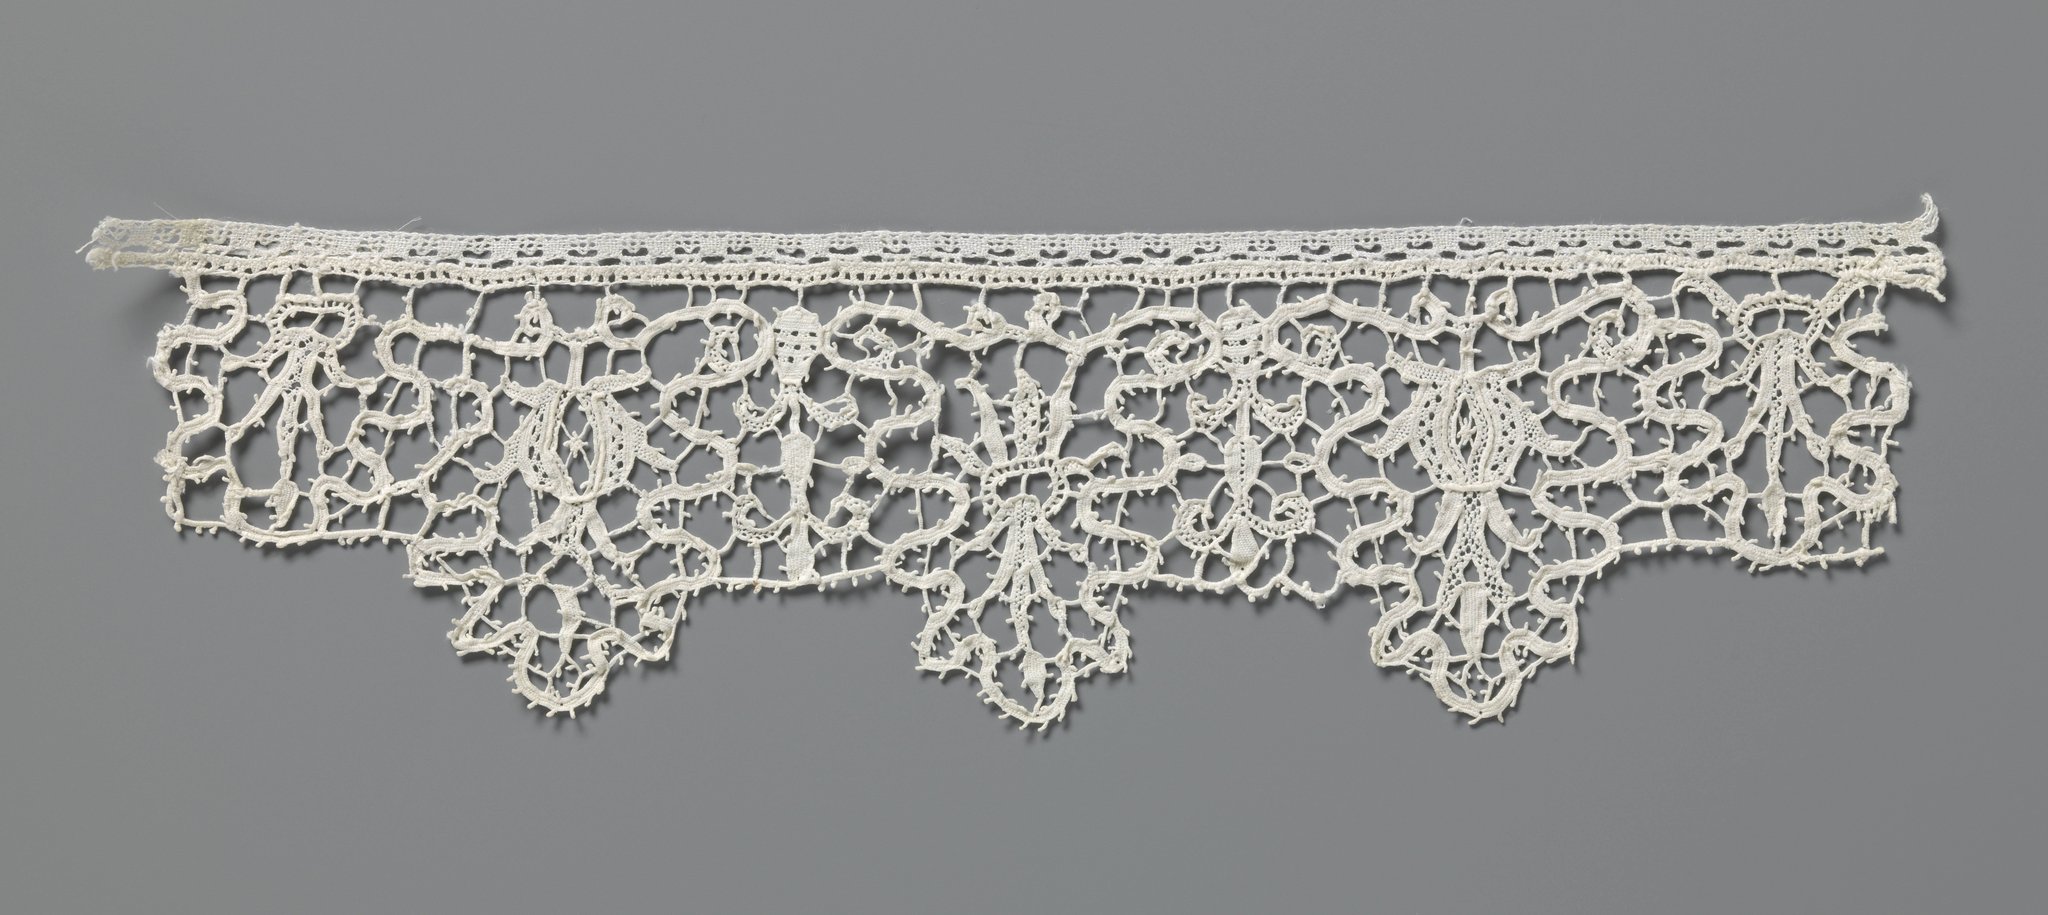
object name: strip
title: Strook naaldkant met granaatappel en stralenkrans in eikenblad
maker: Anonymous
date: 1625-1649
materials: linen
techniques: needle lace, punto in aria, spindle ground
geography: italy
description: Strook naturelkleurig naaldkant: punto in aria. Het zich herhalende patroon bestaat uit de eikenbladcontour waarin afwisselend een granaatappel of stralenkrans staat. Tussen de eikenbladeren staat een Franse lelie. De motieven zijn opgebouwd uit festonsteken, deels voorzien van uitsparingen. De motieven zijn met elkaar verbonden door een onregelmatige, open spijlengrond met picots. De schulpenrand vormt zich vanuit het eikenbladmotief en is afgewerkt met picots. De bovenzijde van de strook is recht afgewerkt met een geklost bandje.